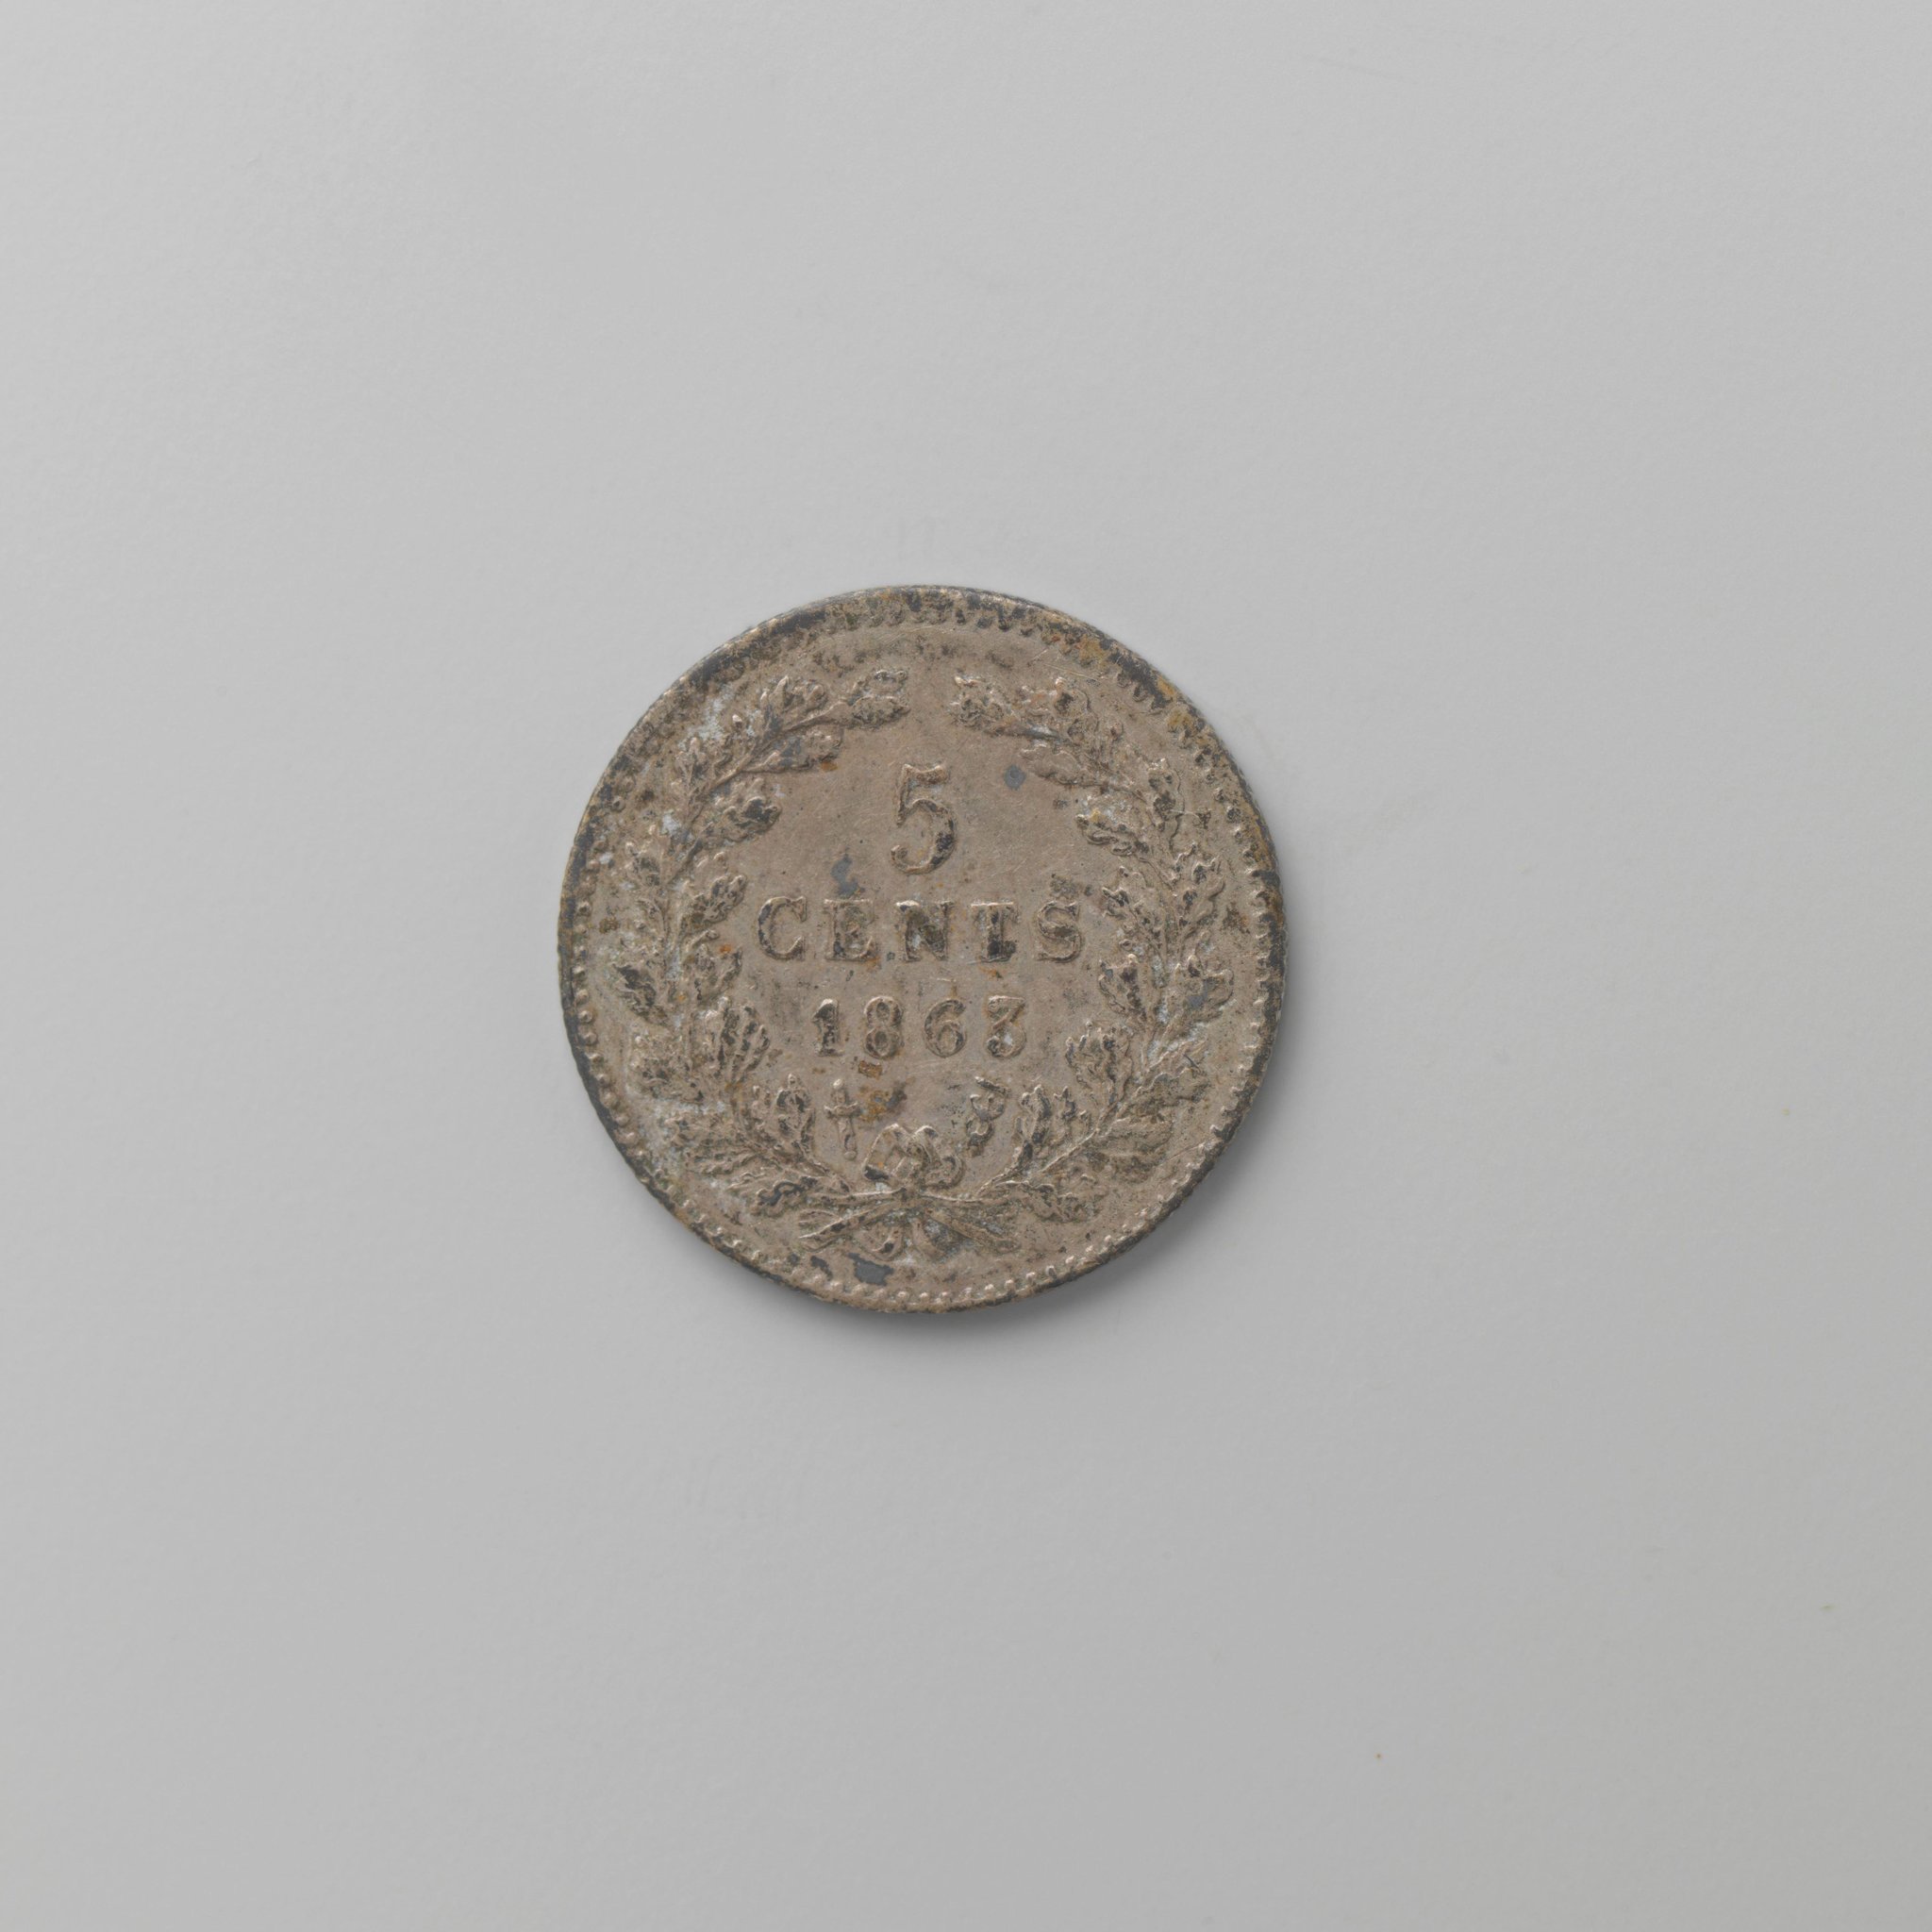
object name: coin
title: Nederlandse 5 cent, 1863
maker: willem iii (koning der nederlanden)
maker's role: koning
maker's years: 1817-1890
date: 1863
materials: silver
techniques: striking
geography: utrecht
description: Zilveren munt. Voorzijde: borstbeeld naar rechts. Keerzijde: binnen twee samengebonden eiketakken waarde-aanduiding 5 cents. Daaronder jaartal. Kartelrand.